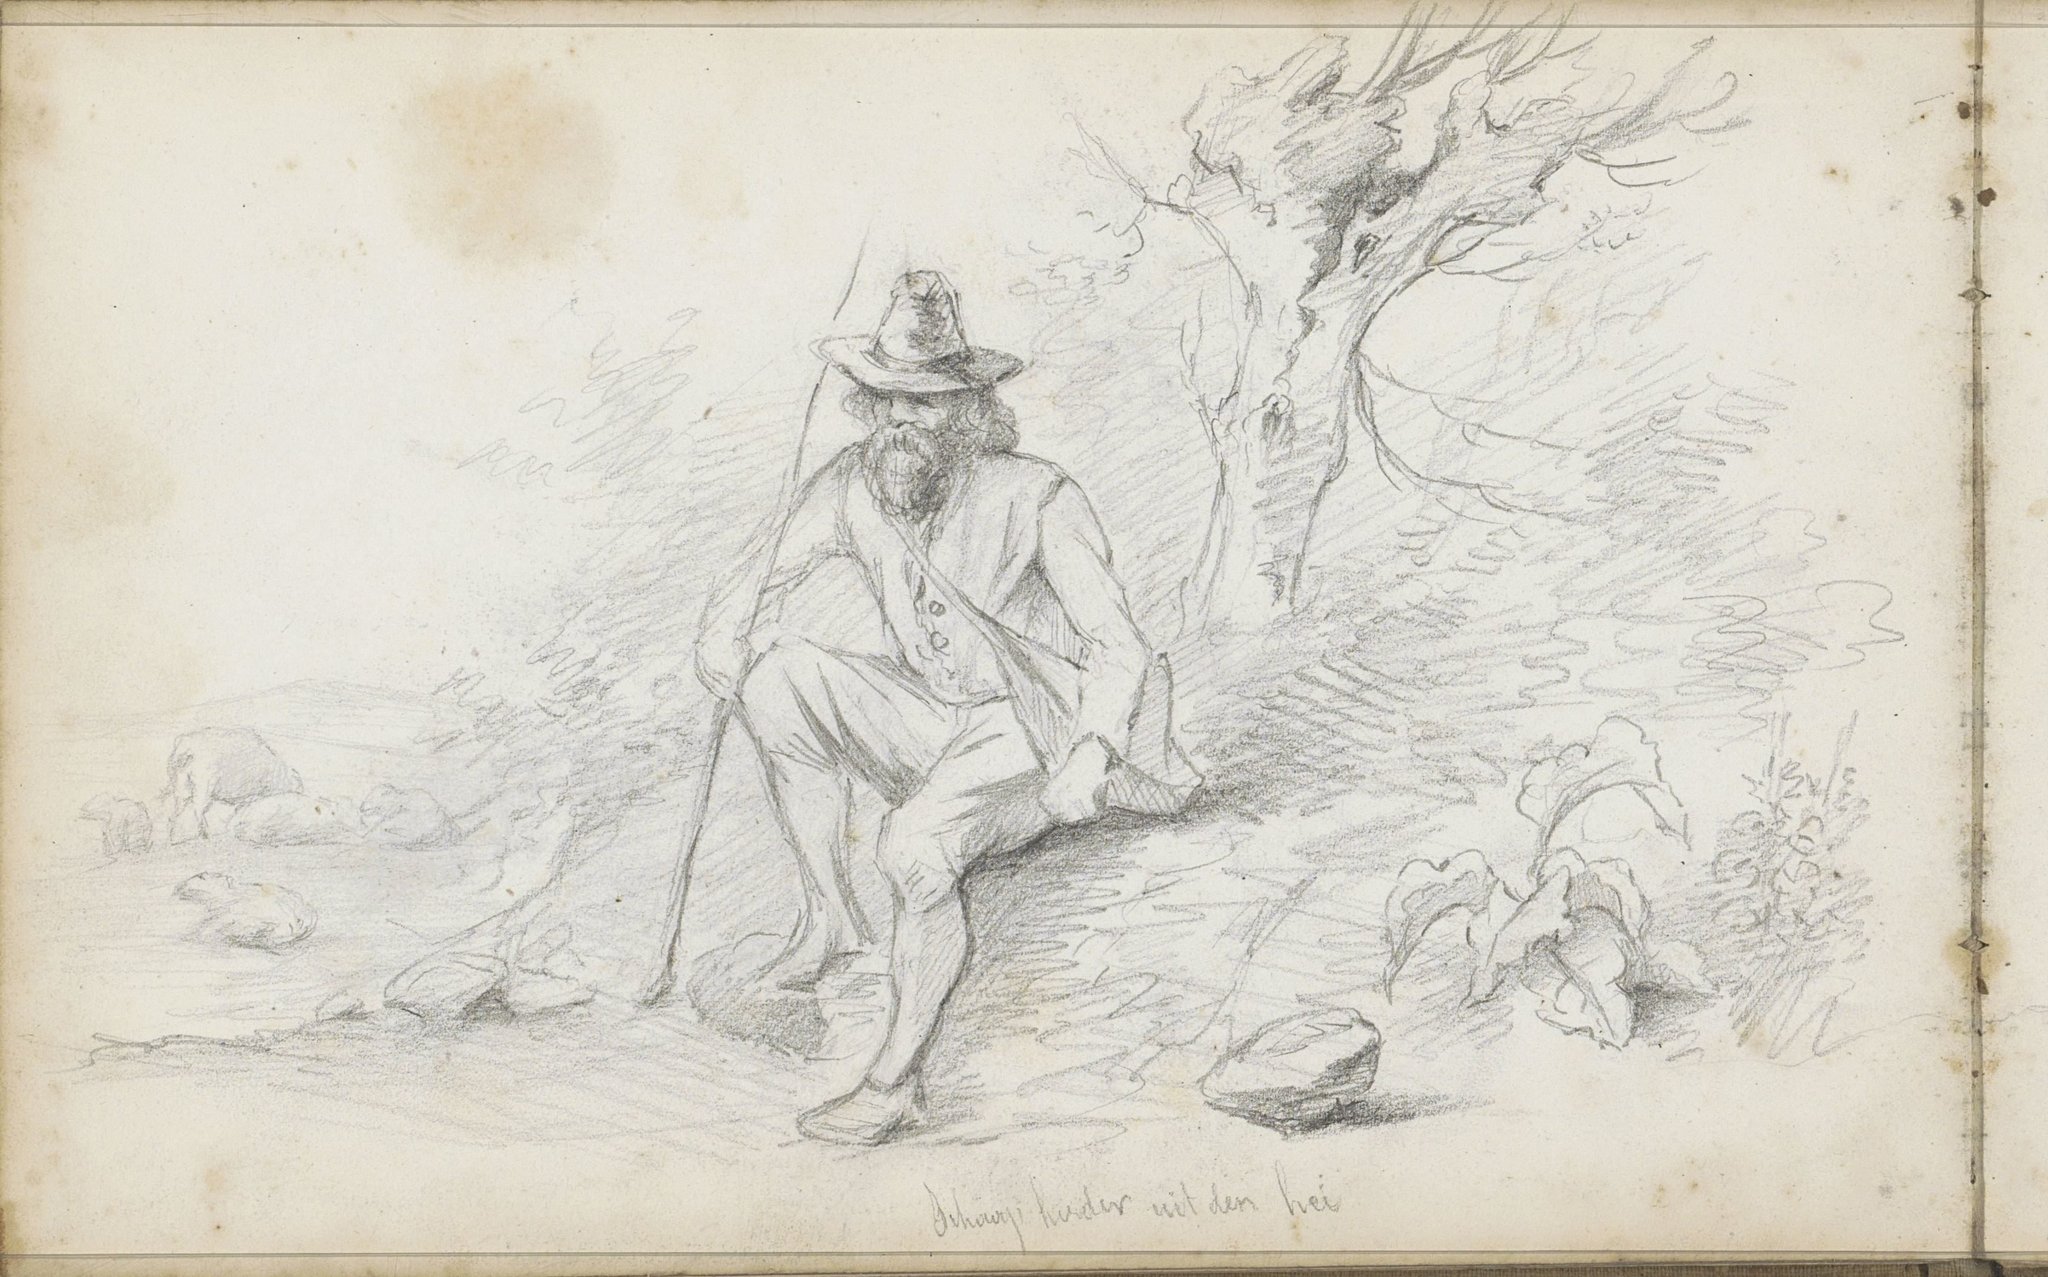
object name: sketchbook leaf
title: Schaapsherder zittend bij een boom op de hei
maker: willem cornelis rip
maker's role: draughtsman, painter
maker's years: 1856-1922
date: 1874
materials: paper, pencil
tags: herding, herdsman, herdswoman, shepherd, shepherdess, cowherd, etc., sheep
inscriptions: annotation: ‘schaapsherder uit den hei’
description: Op de achtergrond graast de kudde schapen. Blad 29 verso uit een schetsboek met 47 bladen.